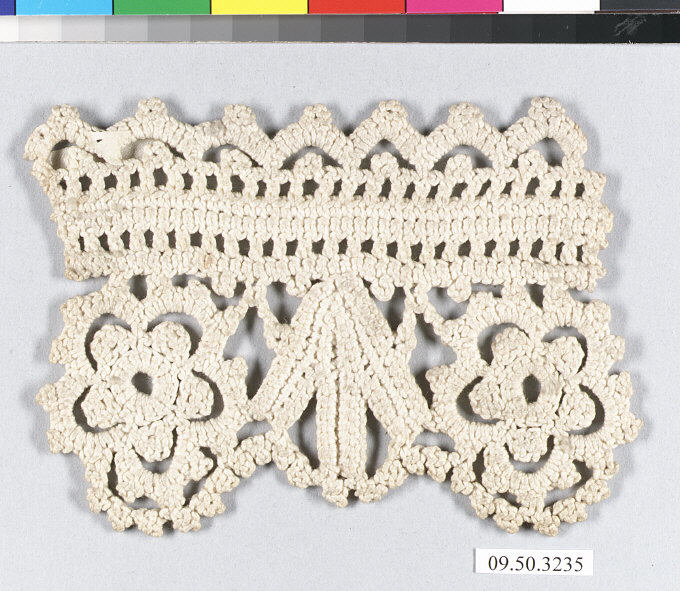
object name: sample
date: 1801-1900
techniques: crochet